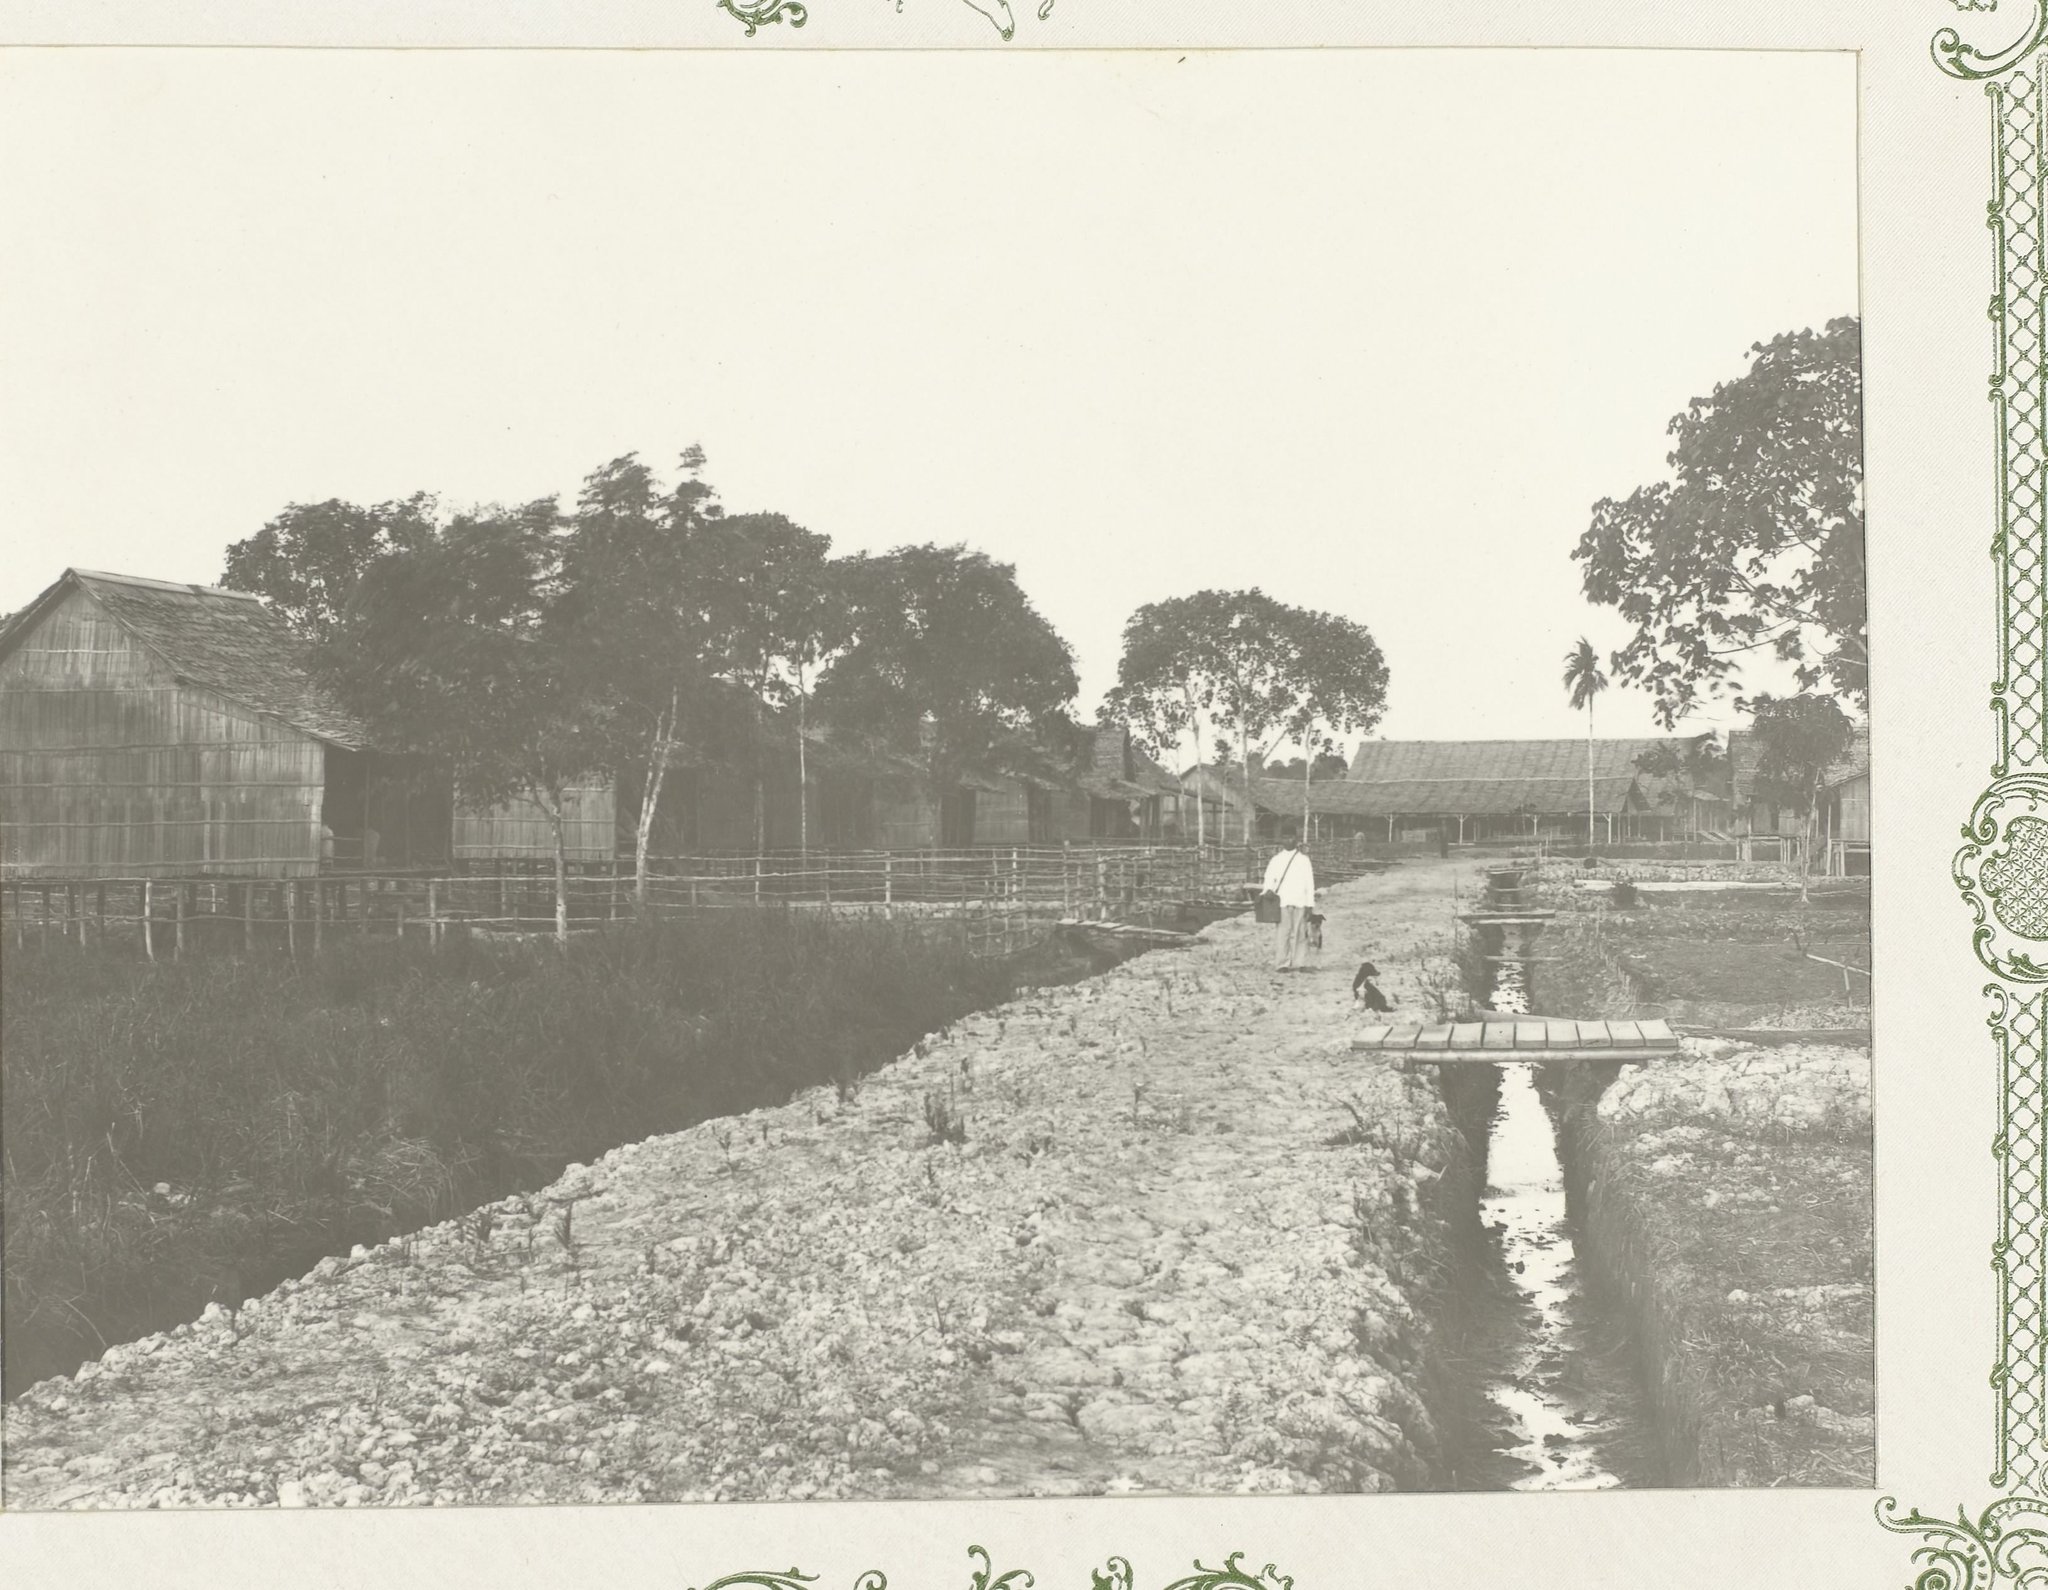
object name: album leaf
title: Nederzettting met gebouwen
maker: Anonymous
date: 1903-1907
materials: paper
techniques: gelatin silver print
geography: kalimantan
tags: village, borneo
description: Een nederzettting met gebouwen, op een pad staat een man met twee honden. Foto in het fotoalbum over de oliewinning op Borneo door de Koninklijke Nederlandsche Petroleum Maatschappij (KNPM) in de jaren 1903-1907.